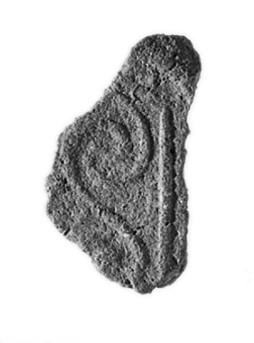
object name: sealing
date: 1981-1640 BCE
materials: mud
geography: egypt